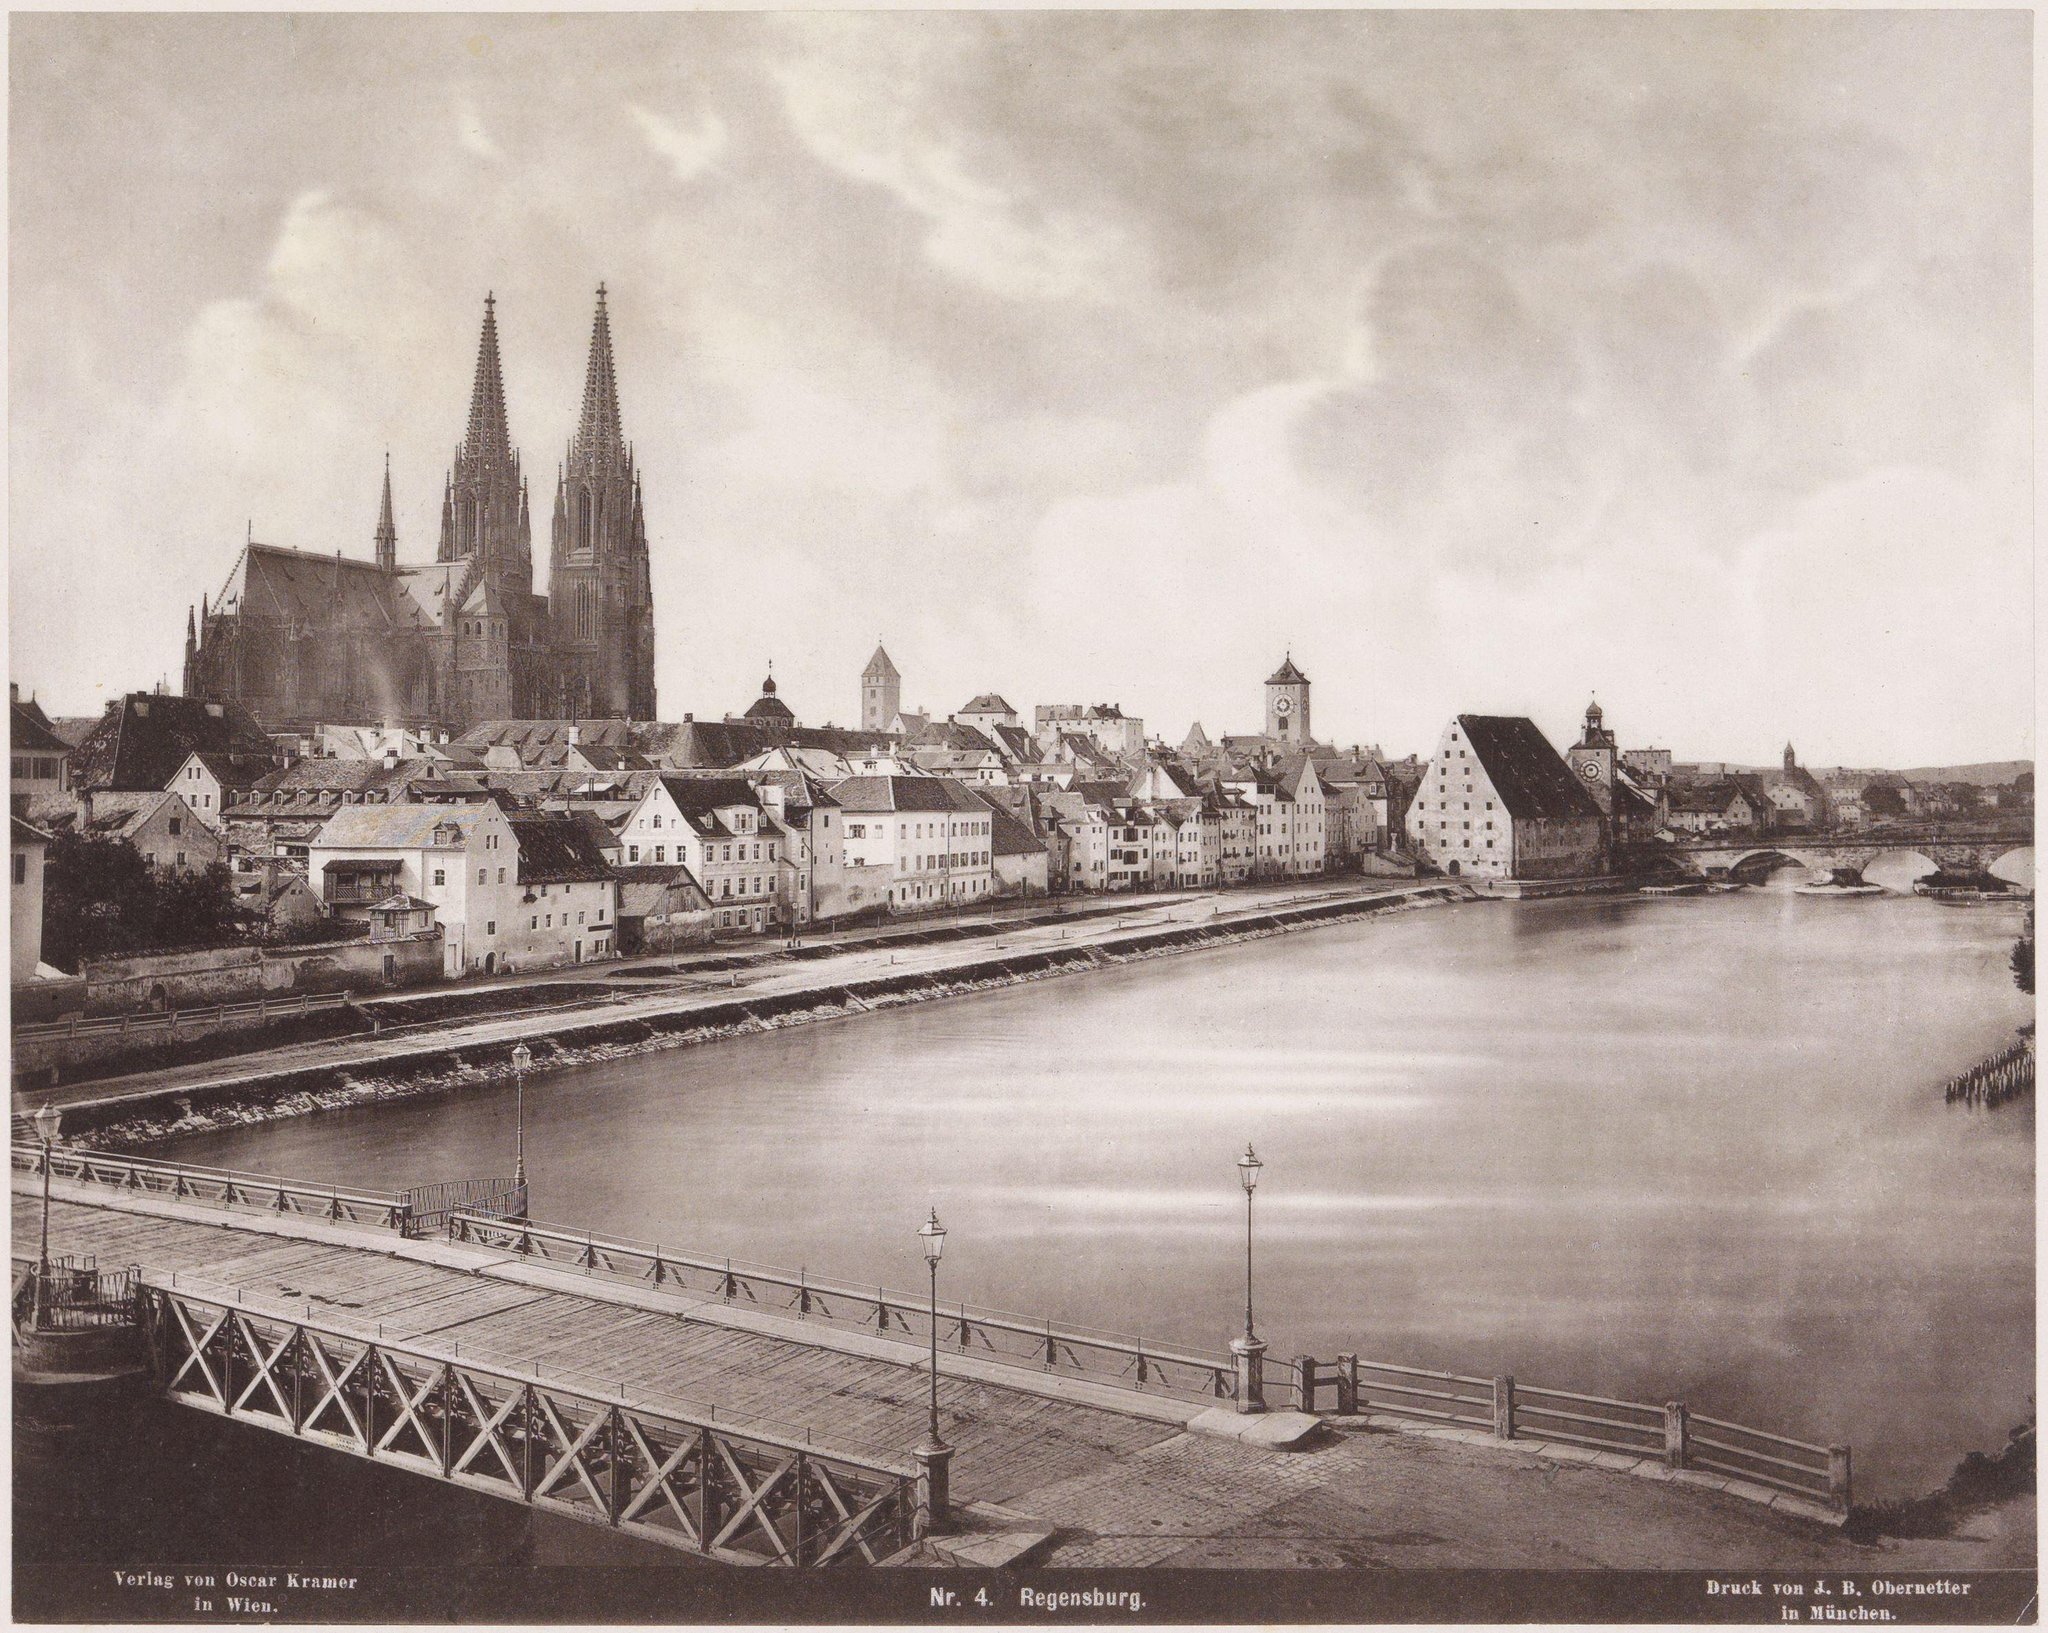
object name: photomechanical print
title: Regensburg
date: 1856-1887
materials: cardboard, paper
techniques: photograph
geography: munich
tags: city-view in general; 'veduta'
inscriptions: number: ‘Nr. 4.’